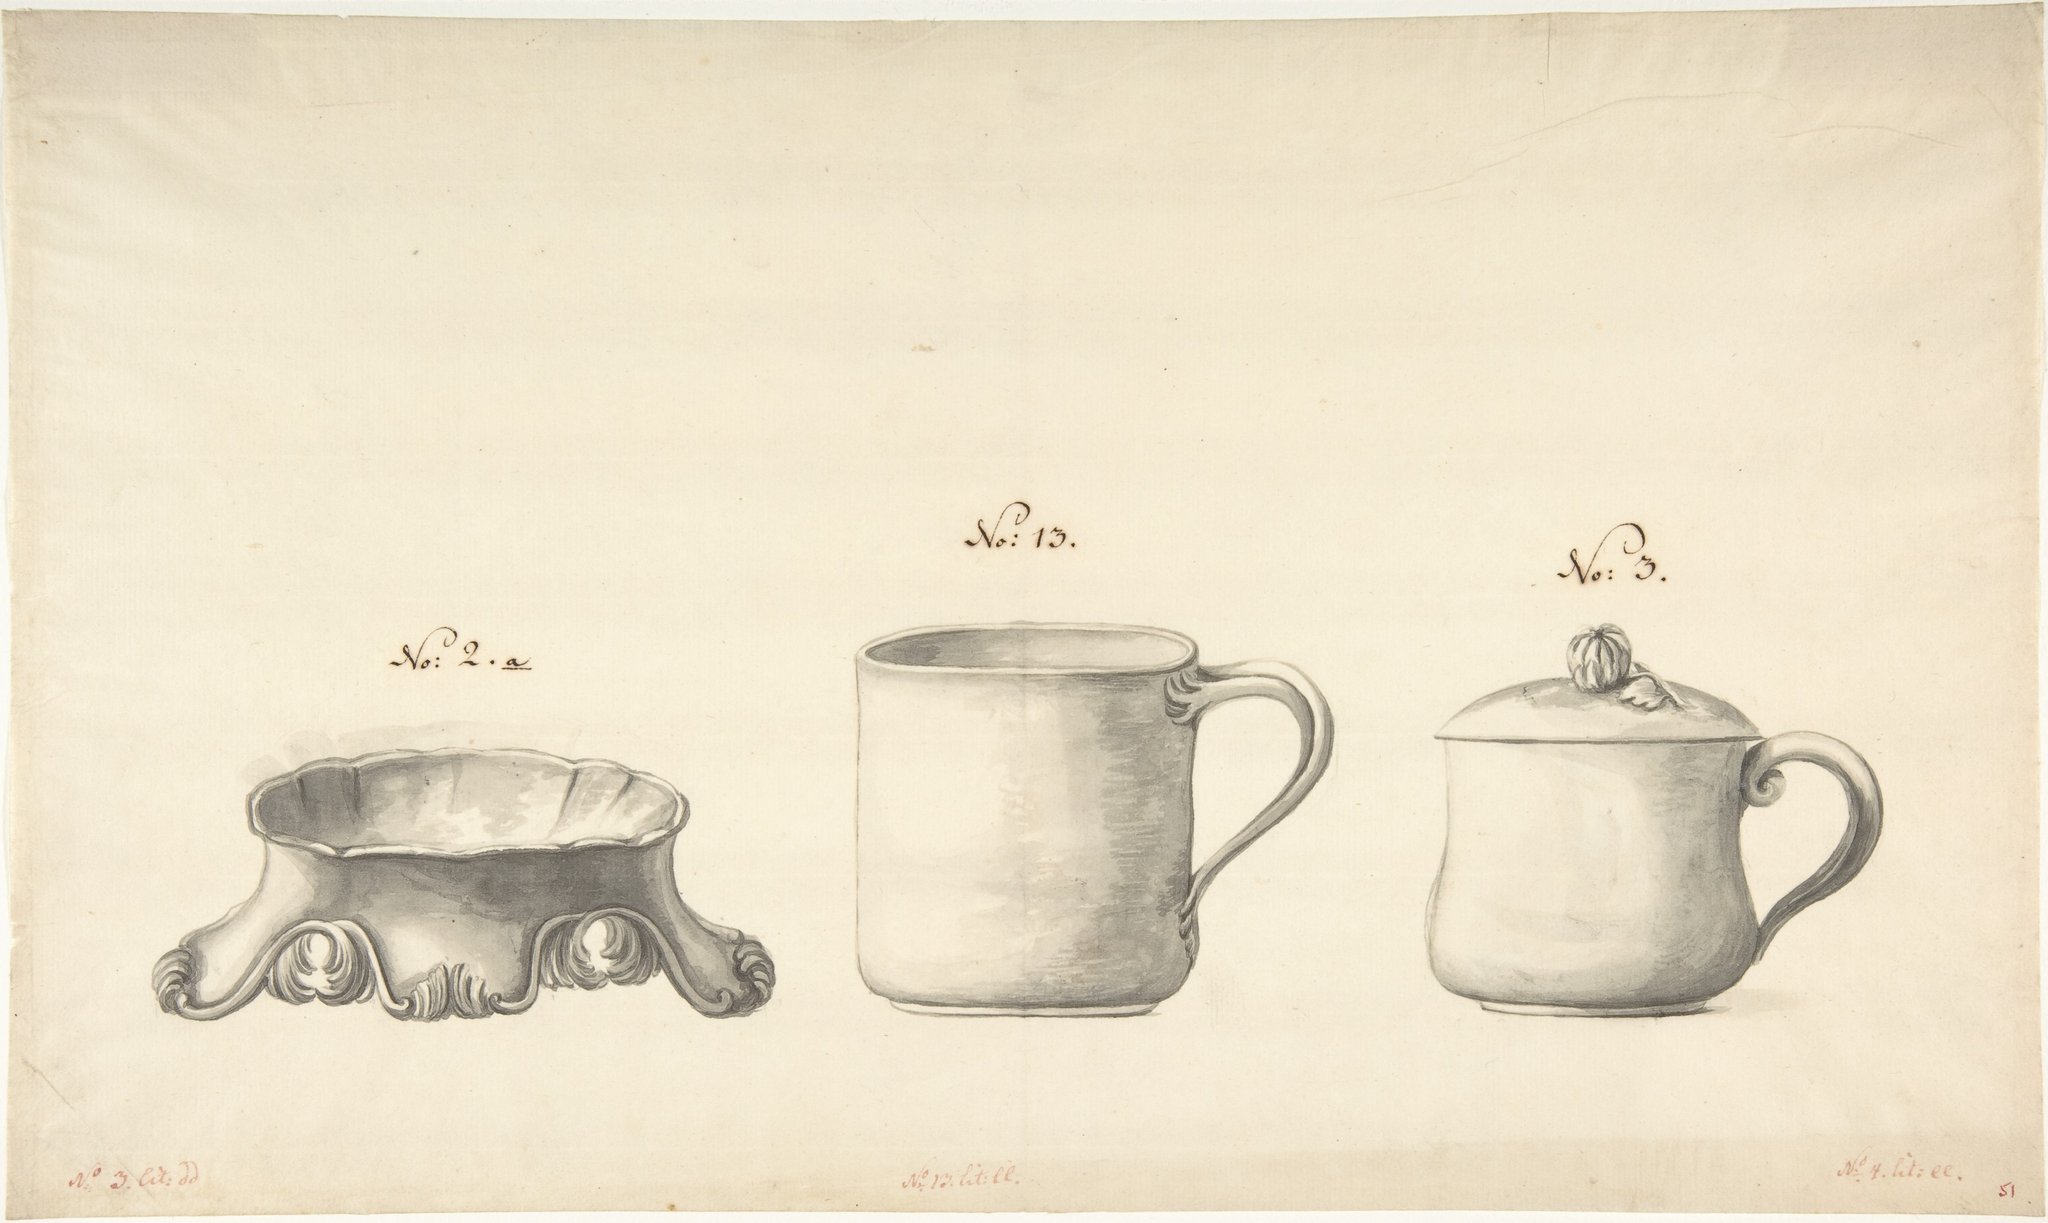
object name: drawing ornament architecture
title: Design for a Salt Celler and Two Cups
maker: anonymous, french, 18th century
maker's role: artist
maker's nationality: french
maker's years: 1700-1800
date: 1770-1790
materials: ink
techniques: brush, pen, wash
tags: cups